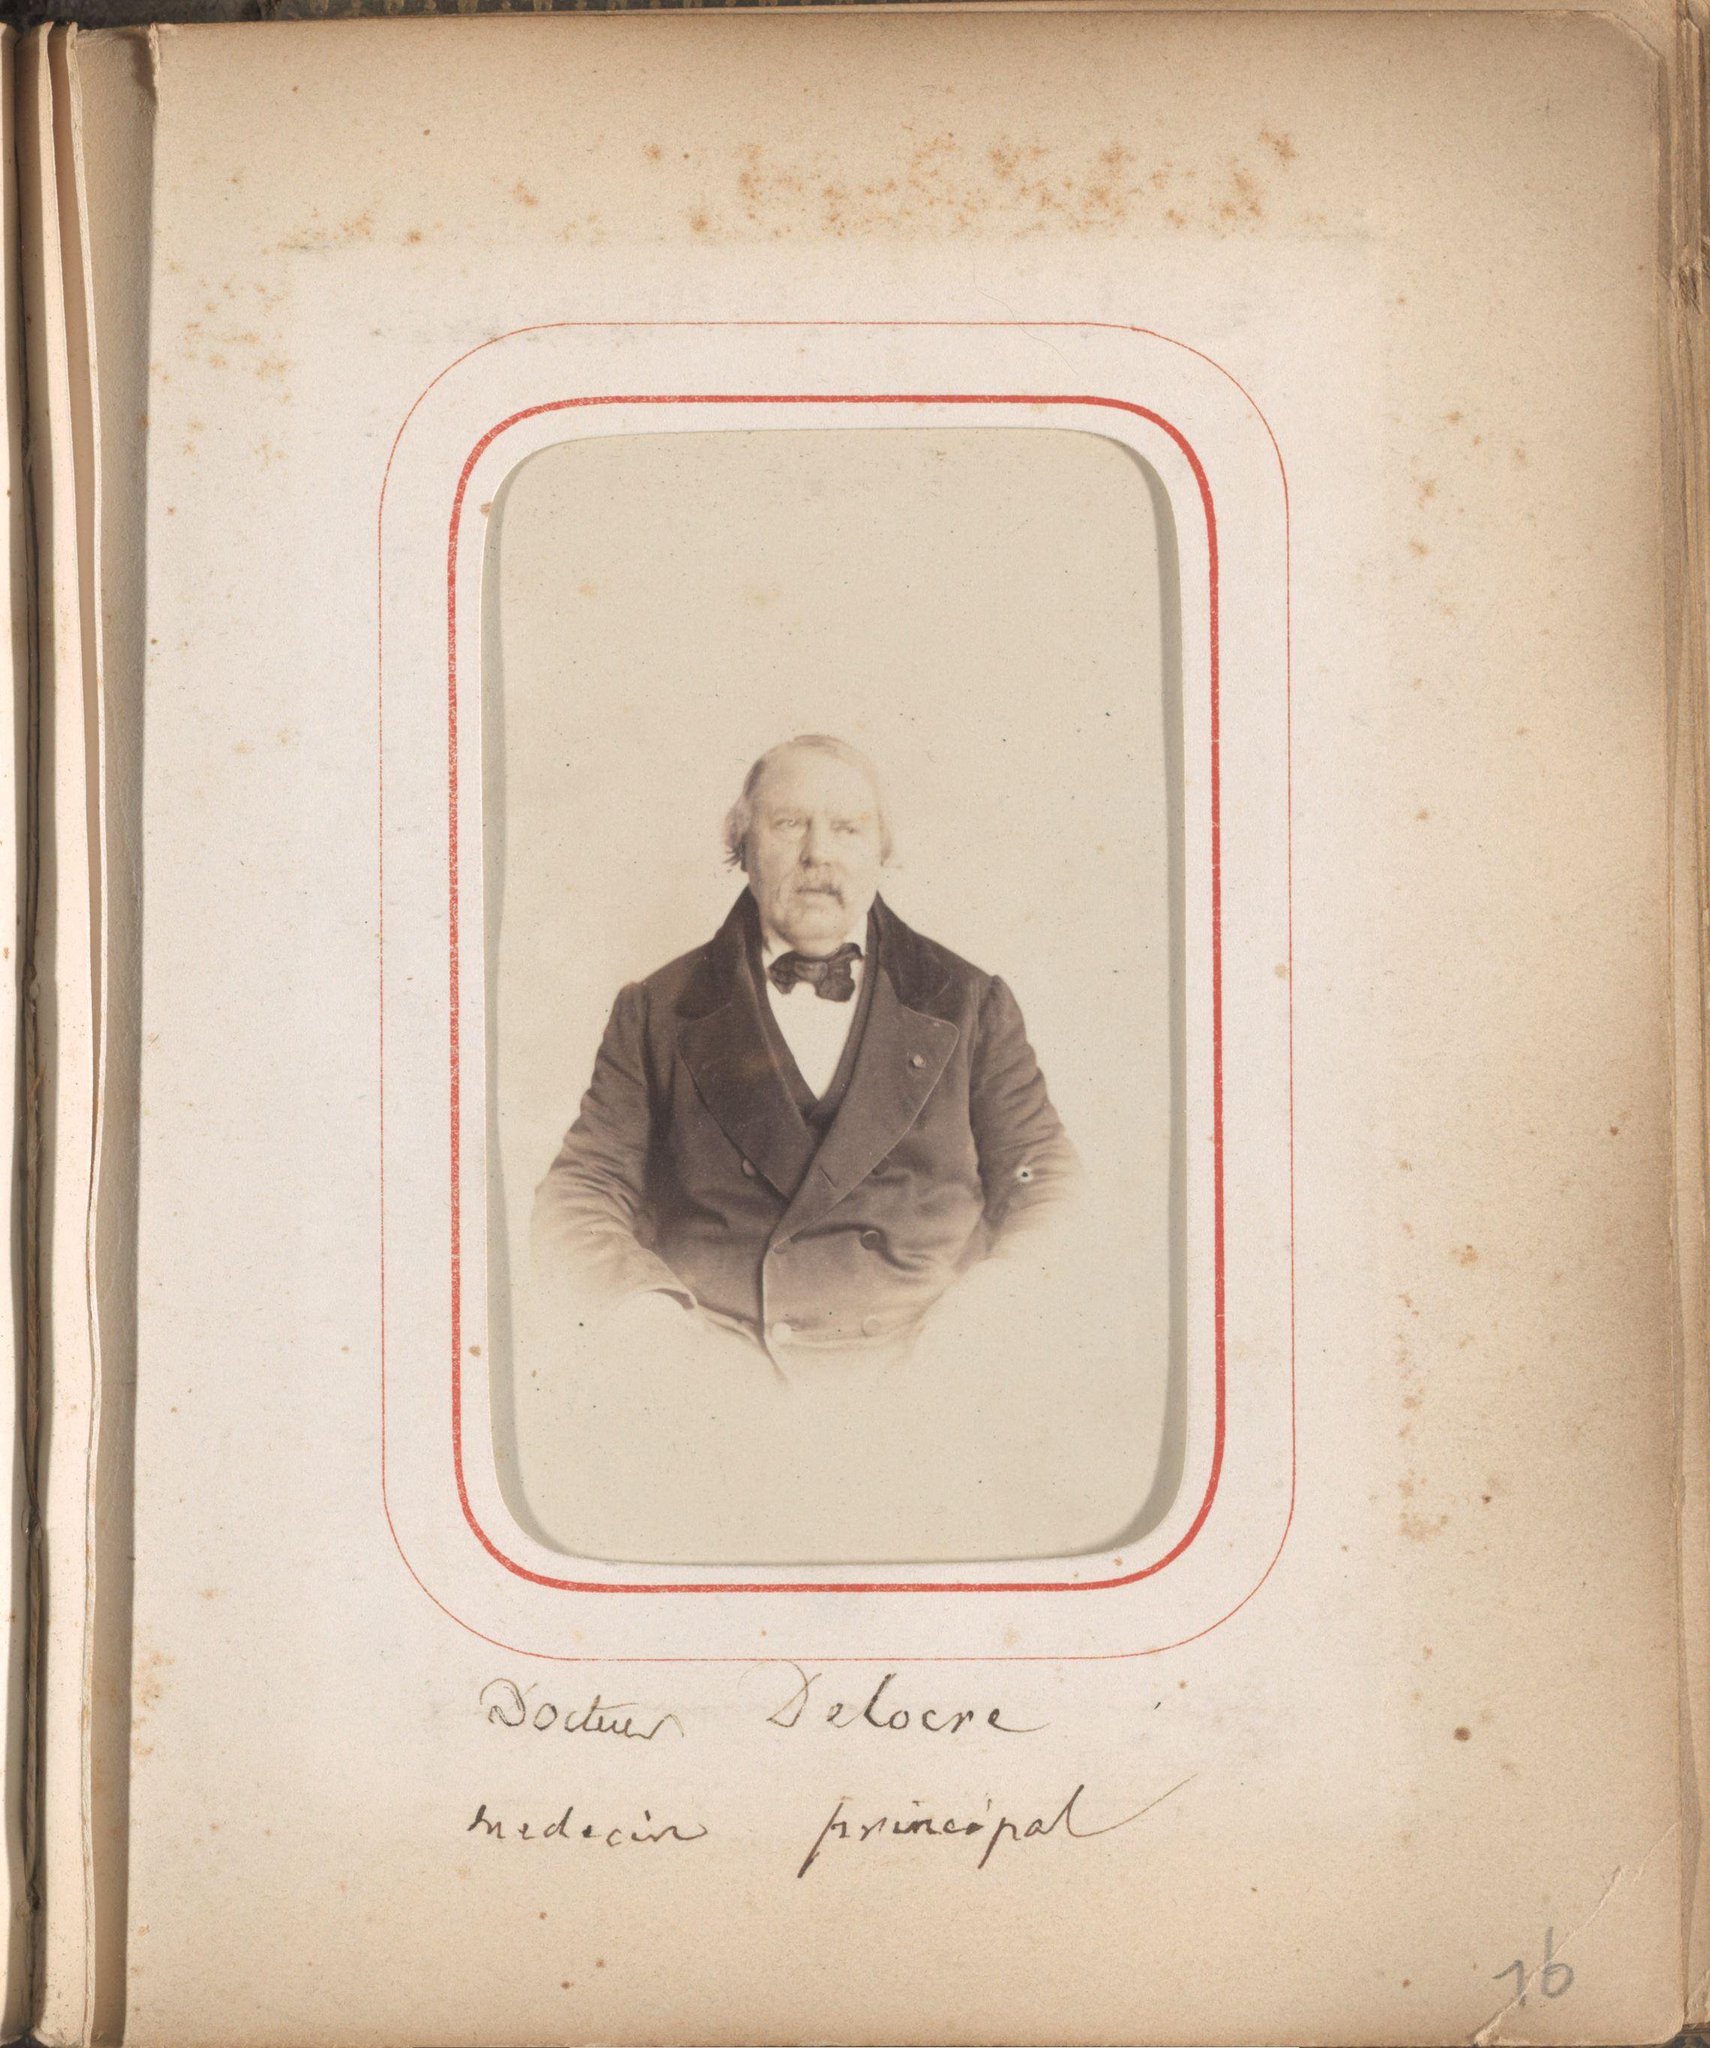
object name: carte de visite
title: Portret van dokter Delocre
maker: Anonymous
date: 1862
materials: cardboard, paper, photographic support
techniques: albumen print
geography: lyon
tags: studio requisites ~ photographer, historical persons, neck-gear ~ clothing, clothing for the upper part of the body, beard, lyon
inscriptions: name: ‘Docteur Delocre medicin principal’, address: ‘Lyon’, date: ‘le 3 Avril 1862’